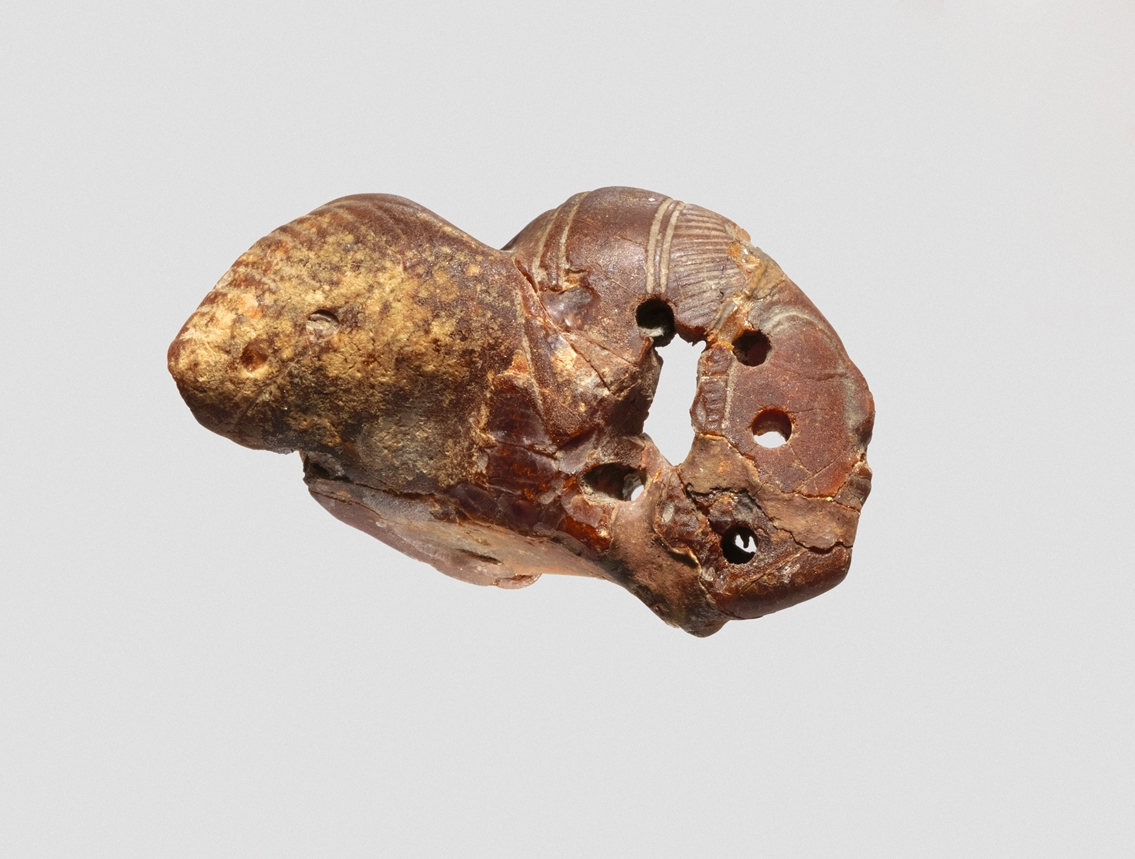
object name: head fragment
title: Pendant: winged female head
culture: italic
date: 500-401 BCE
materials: amber